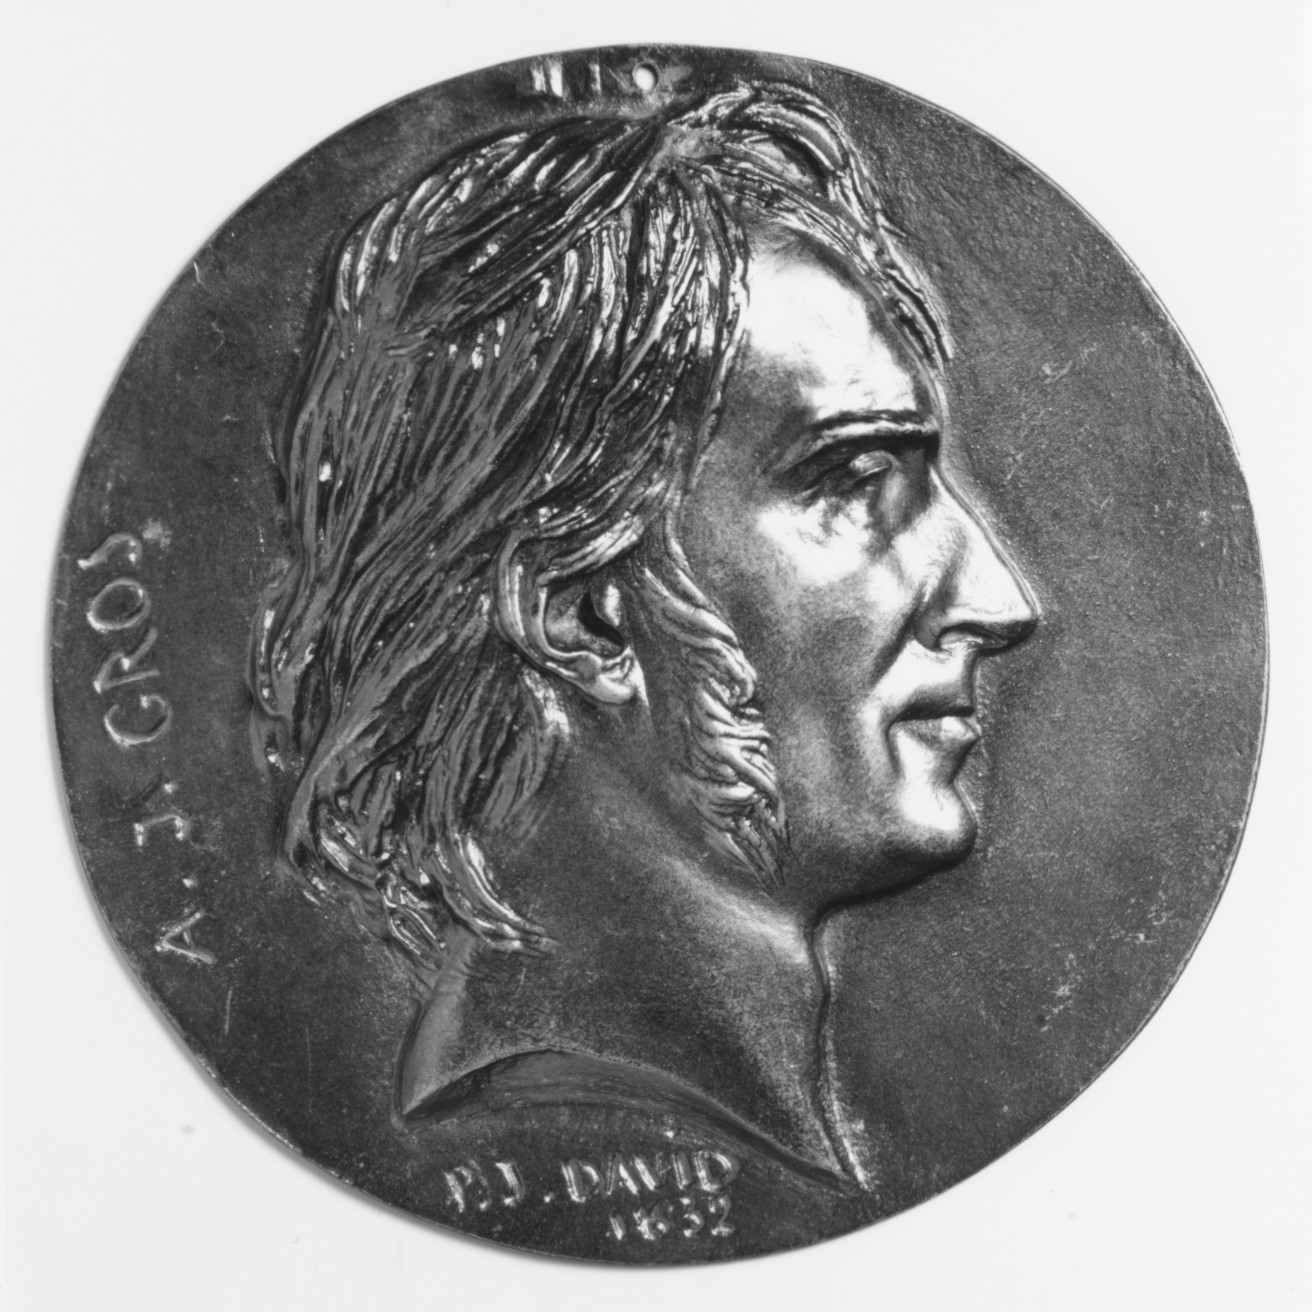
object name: medallion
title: Antoine-Jean Gros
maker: pierre jean david d'angers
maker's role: artist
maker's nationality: french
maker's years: 1788-1856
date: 1832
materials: bronze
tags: men,profiles